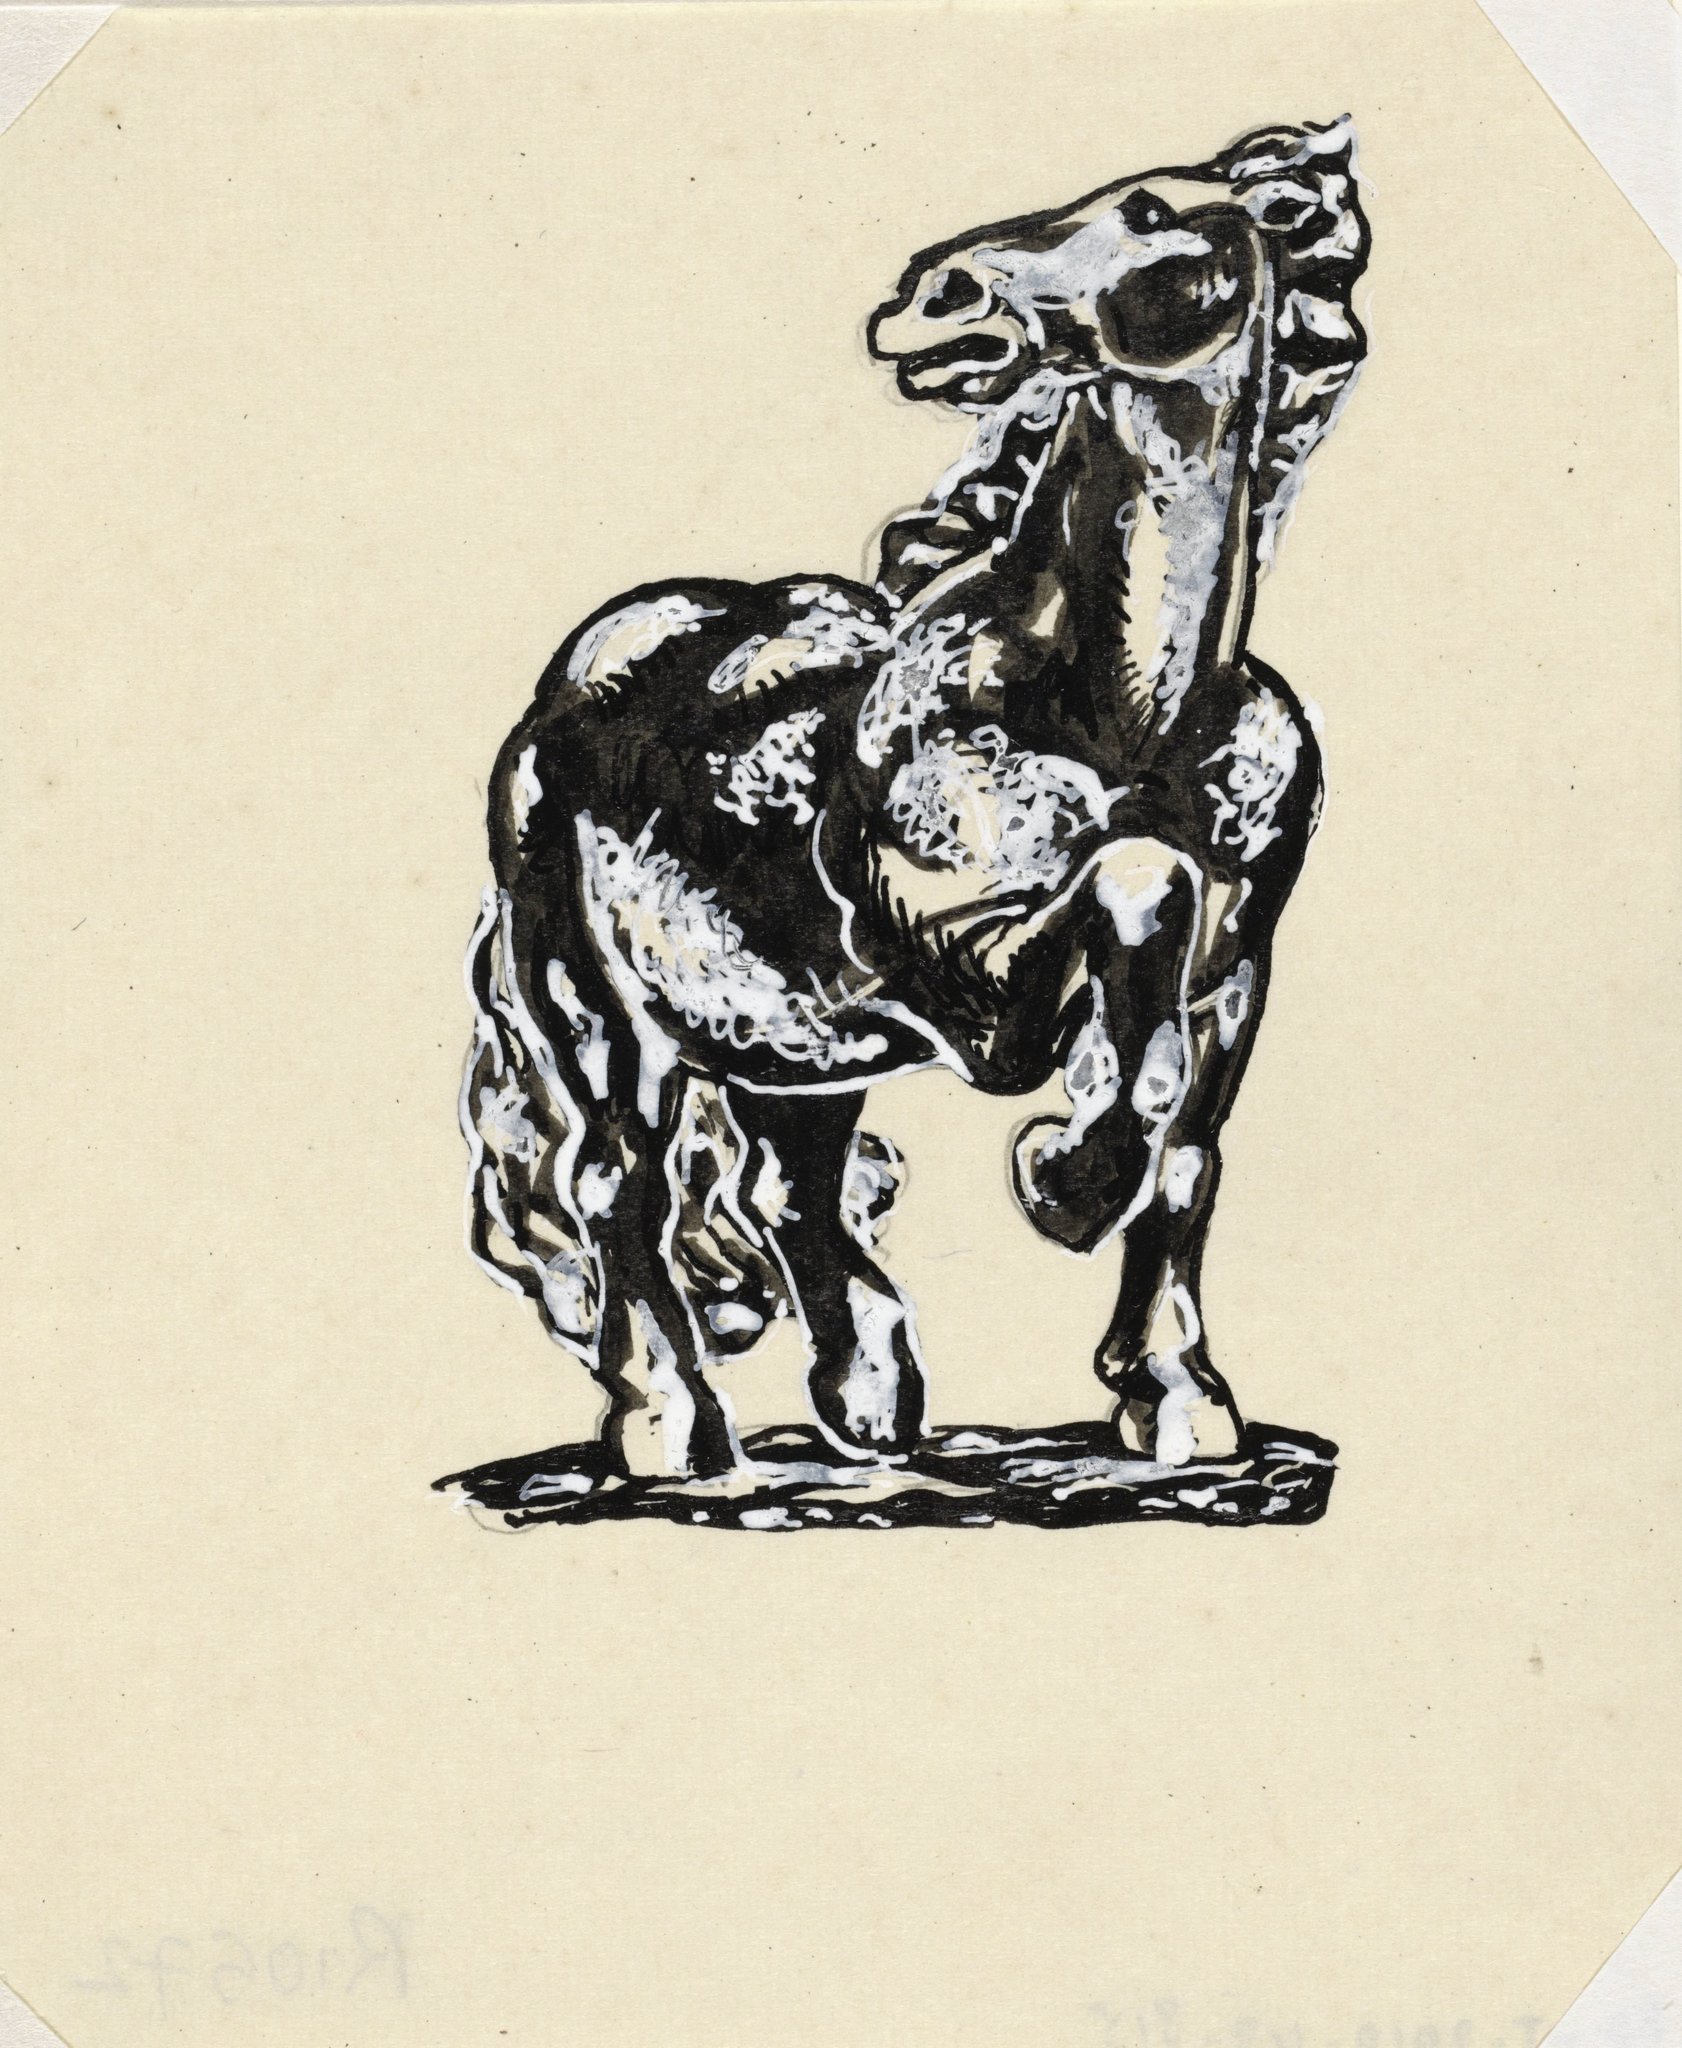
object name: drawing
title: Zonder titel (paard)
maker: leo gestel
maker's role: draughtsman, print maker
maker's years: 1881-1941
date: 1925-1940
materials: paint, ink, paper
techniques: brush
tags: horse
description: Paard met hoofd naar links en rechter voorbeen omhoog